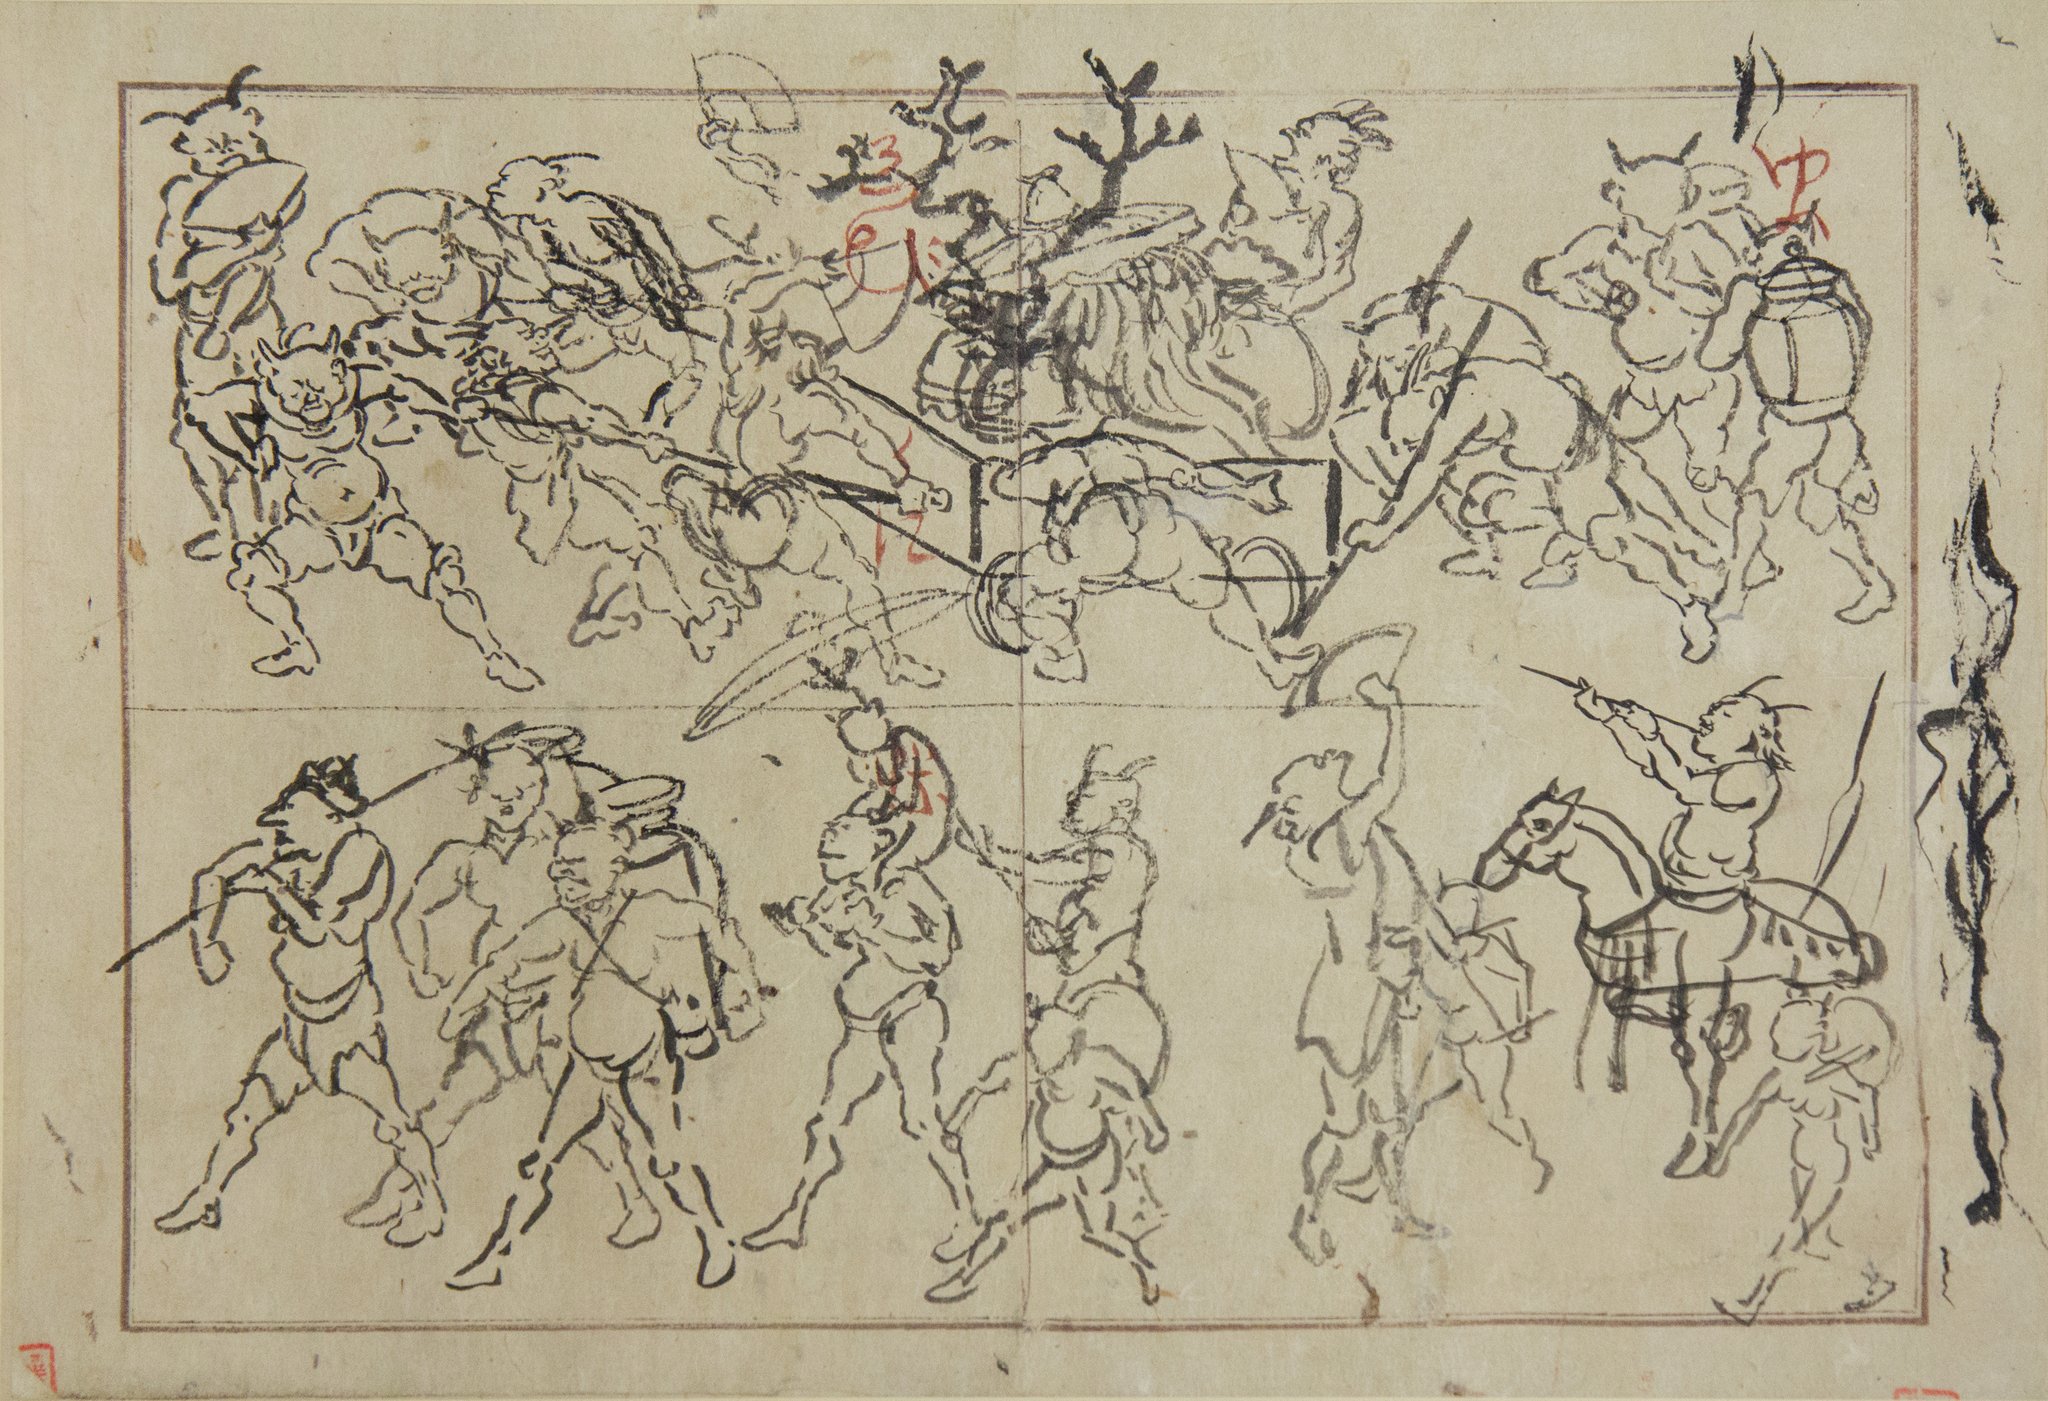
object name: drawing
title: Preliminary Drawings of Demons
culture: japanese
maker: kawanabe kyōsai 河鍋暁斎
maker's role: artist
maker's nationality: japanese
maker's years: 1831-1889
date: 1867-1900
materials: ink, paper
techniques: drawing, wash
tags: demons